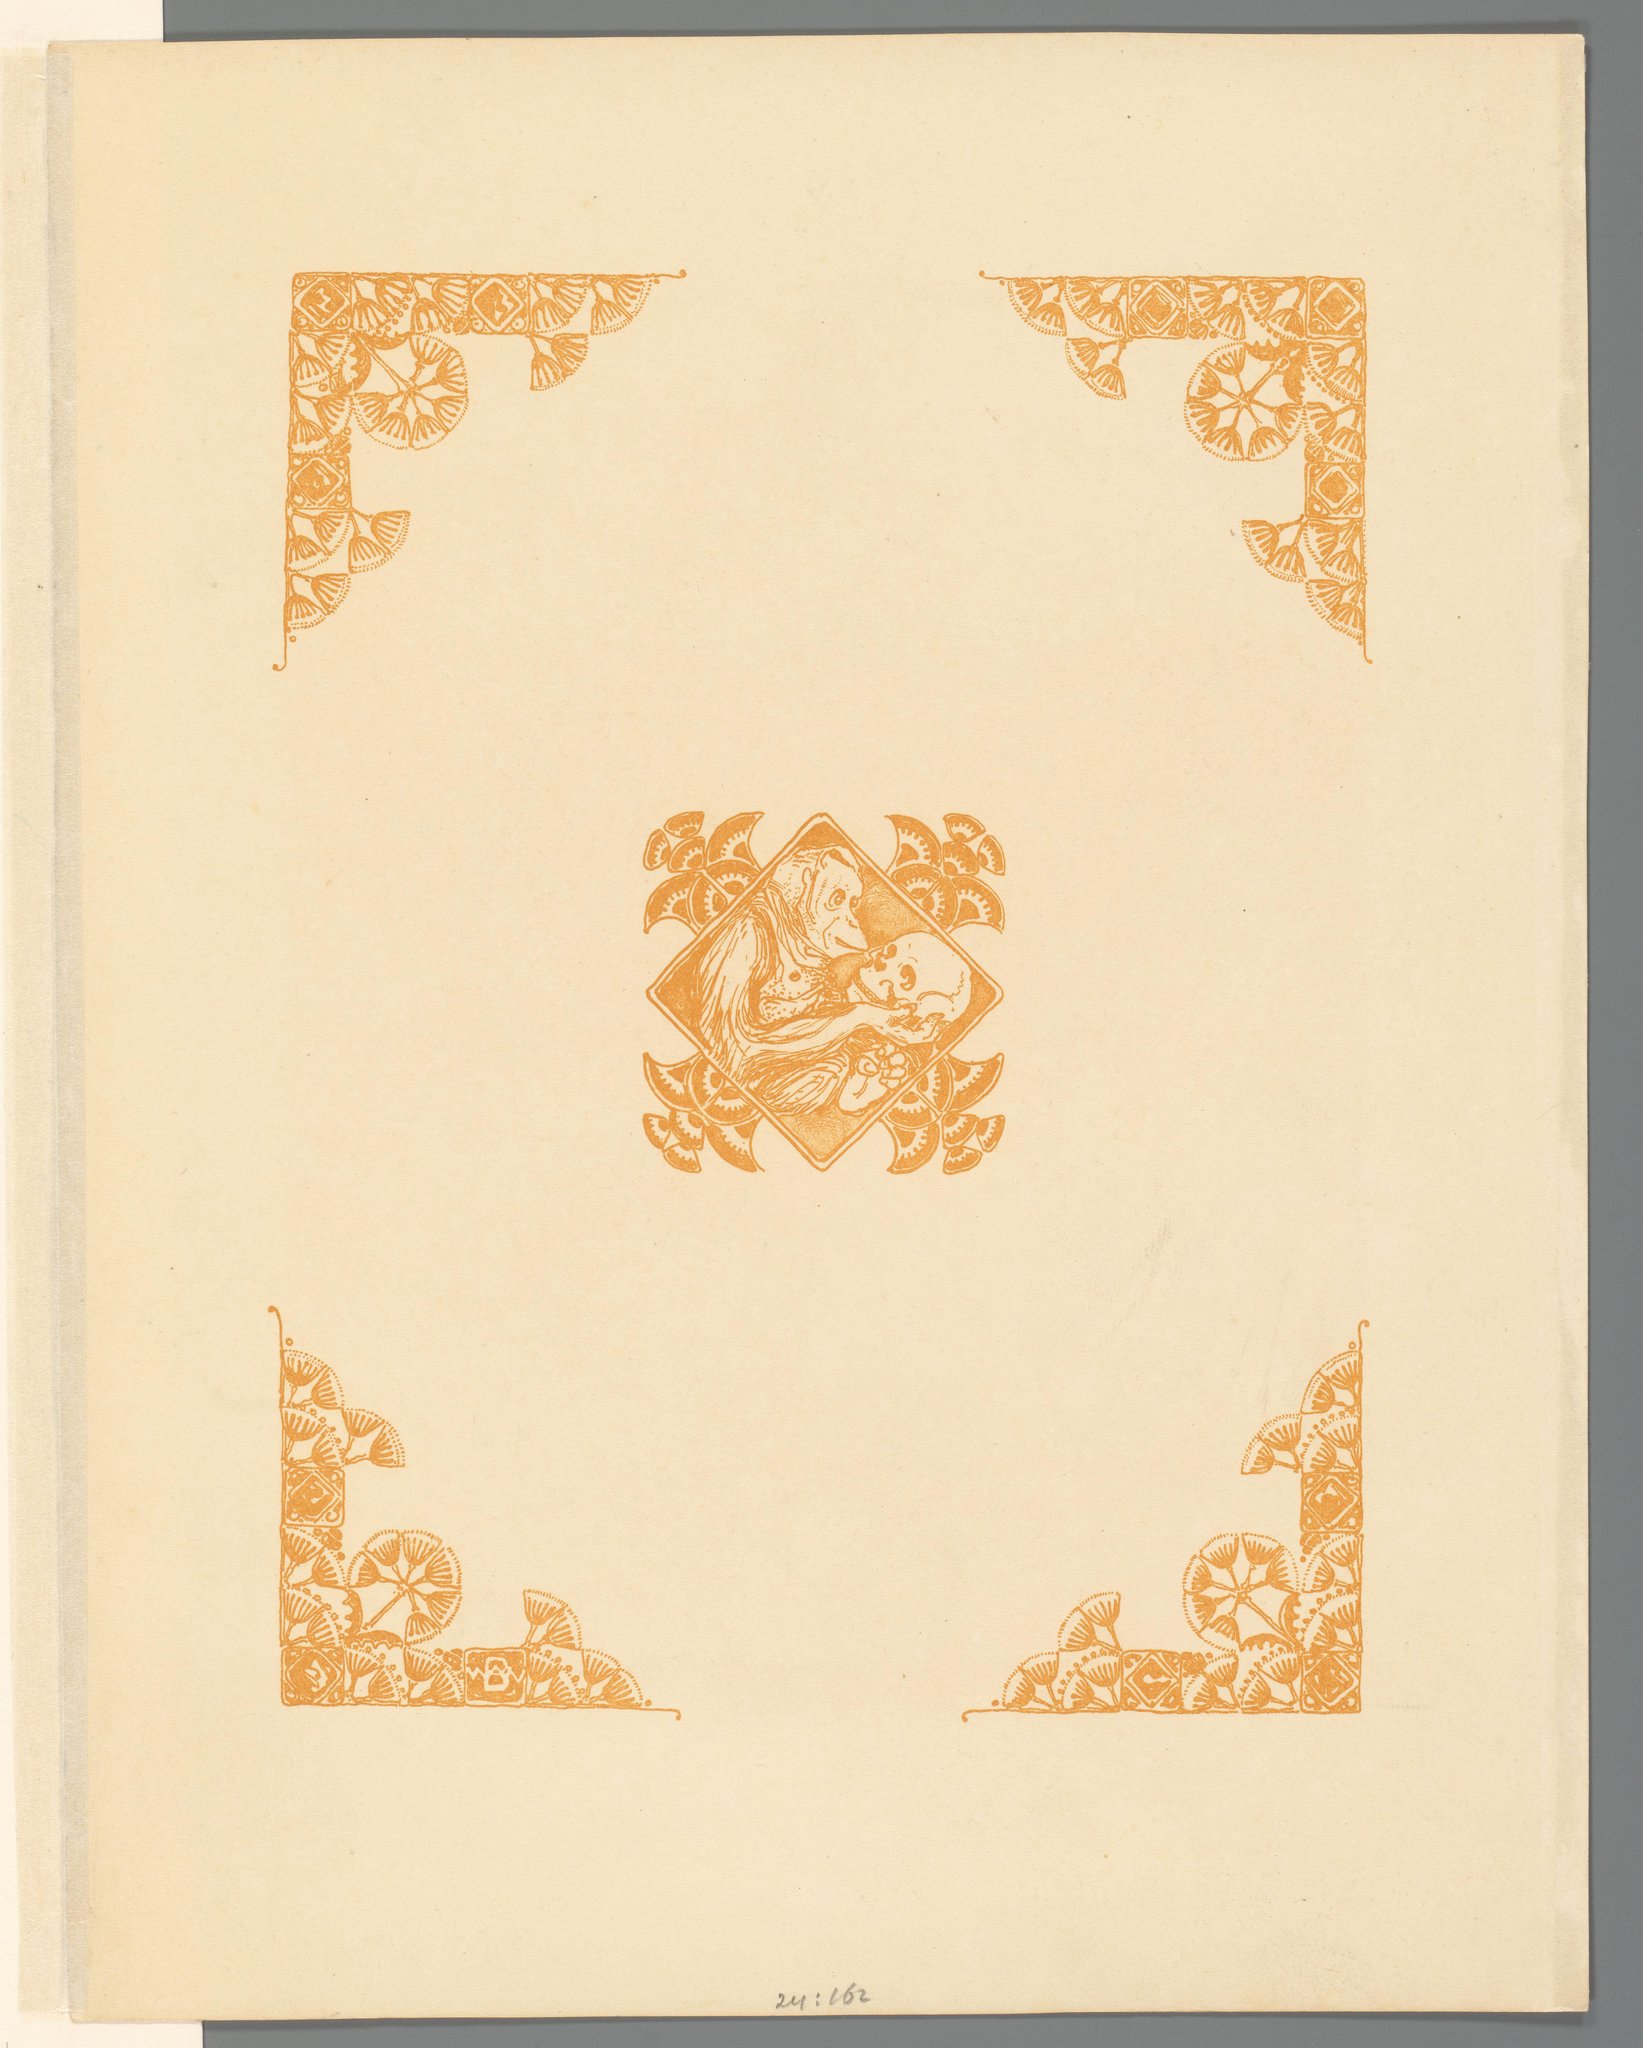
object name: book illustration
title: Ornamentiek en een aap met een schedel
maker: bernard willem wierink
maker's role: draughtsman, print maker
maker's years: 1856-1939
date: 1910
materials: paper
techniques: lithograph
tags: fable of reynard the fox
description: Prent gebruikt in: Streuvels, Stijn (Frank Lateur). Reinaert de Vos naar verschillende uitgaven van het middeleeuwsche epos. Amsterdam: L.J. Veen, 1910.